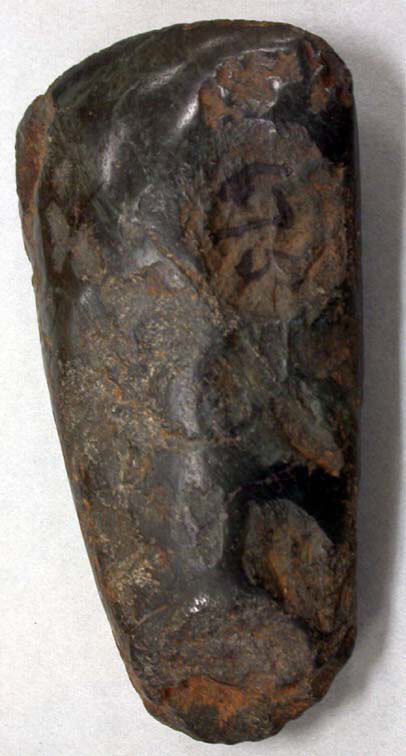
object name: hatchet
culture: papua new guinean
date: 1902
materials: jade